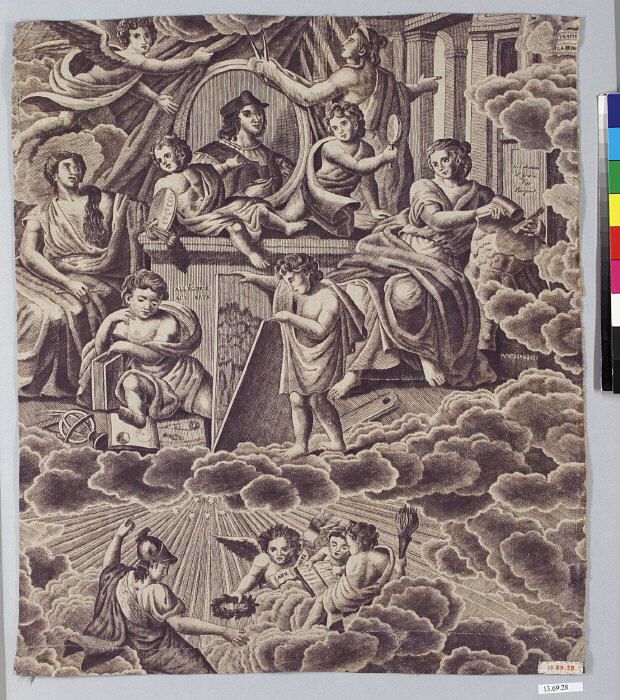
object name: piece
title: The Fine Arts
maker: alexandre buquet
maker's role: designer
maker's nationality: french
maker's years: 1802-1865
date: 1830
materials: cotton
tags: men,women,putti,clouds